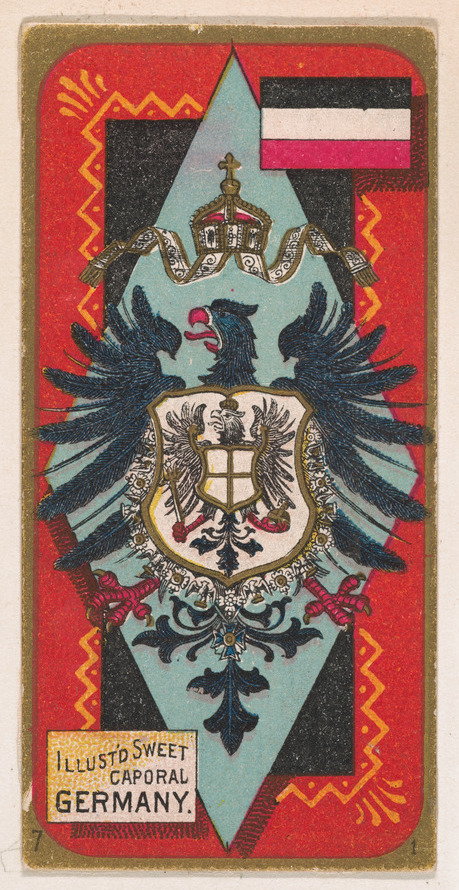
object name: print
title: Coat of Arms, Germany, from the Military Series (N224) issued by Kinney Tobacco Company to promote Sweet Caporal Cigarettes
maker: kinney brothers tobacco company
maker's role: publisher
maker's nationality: american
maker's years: 1869-2011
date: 1888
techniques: color lithograph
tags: eagles,coat of arms